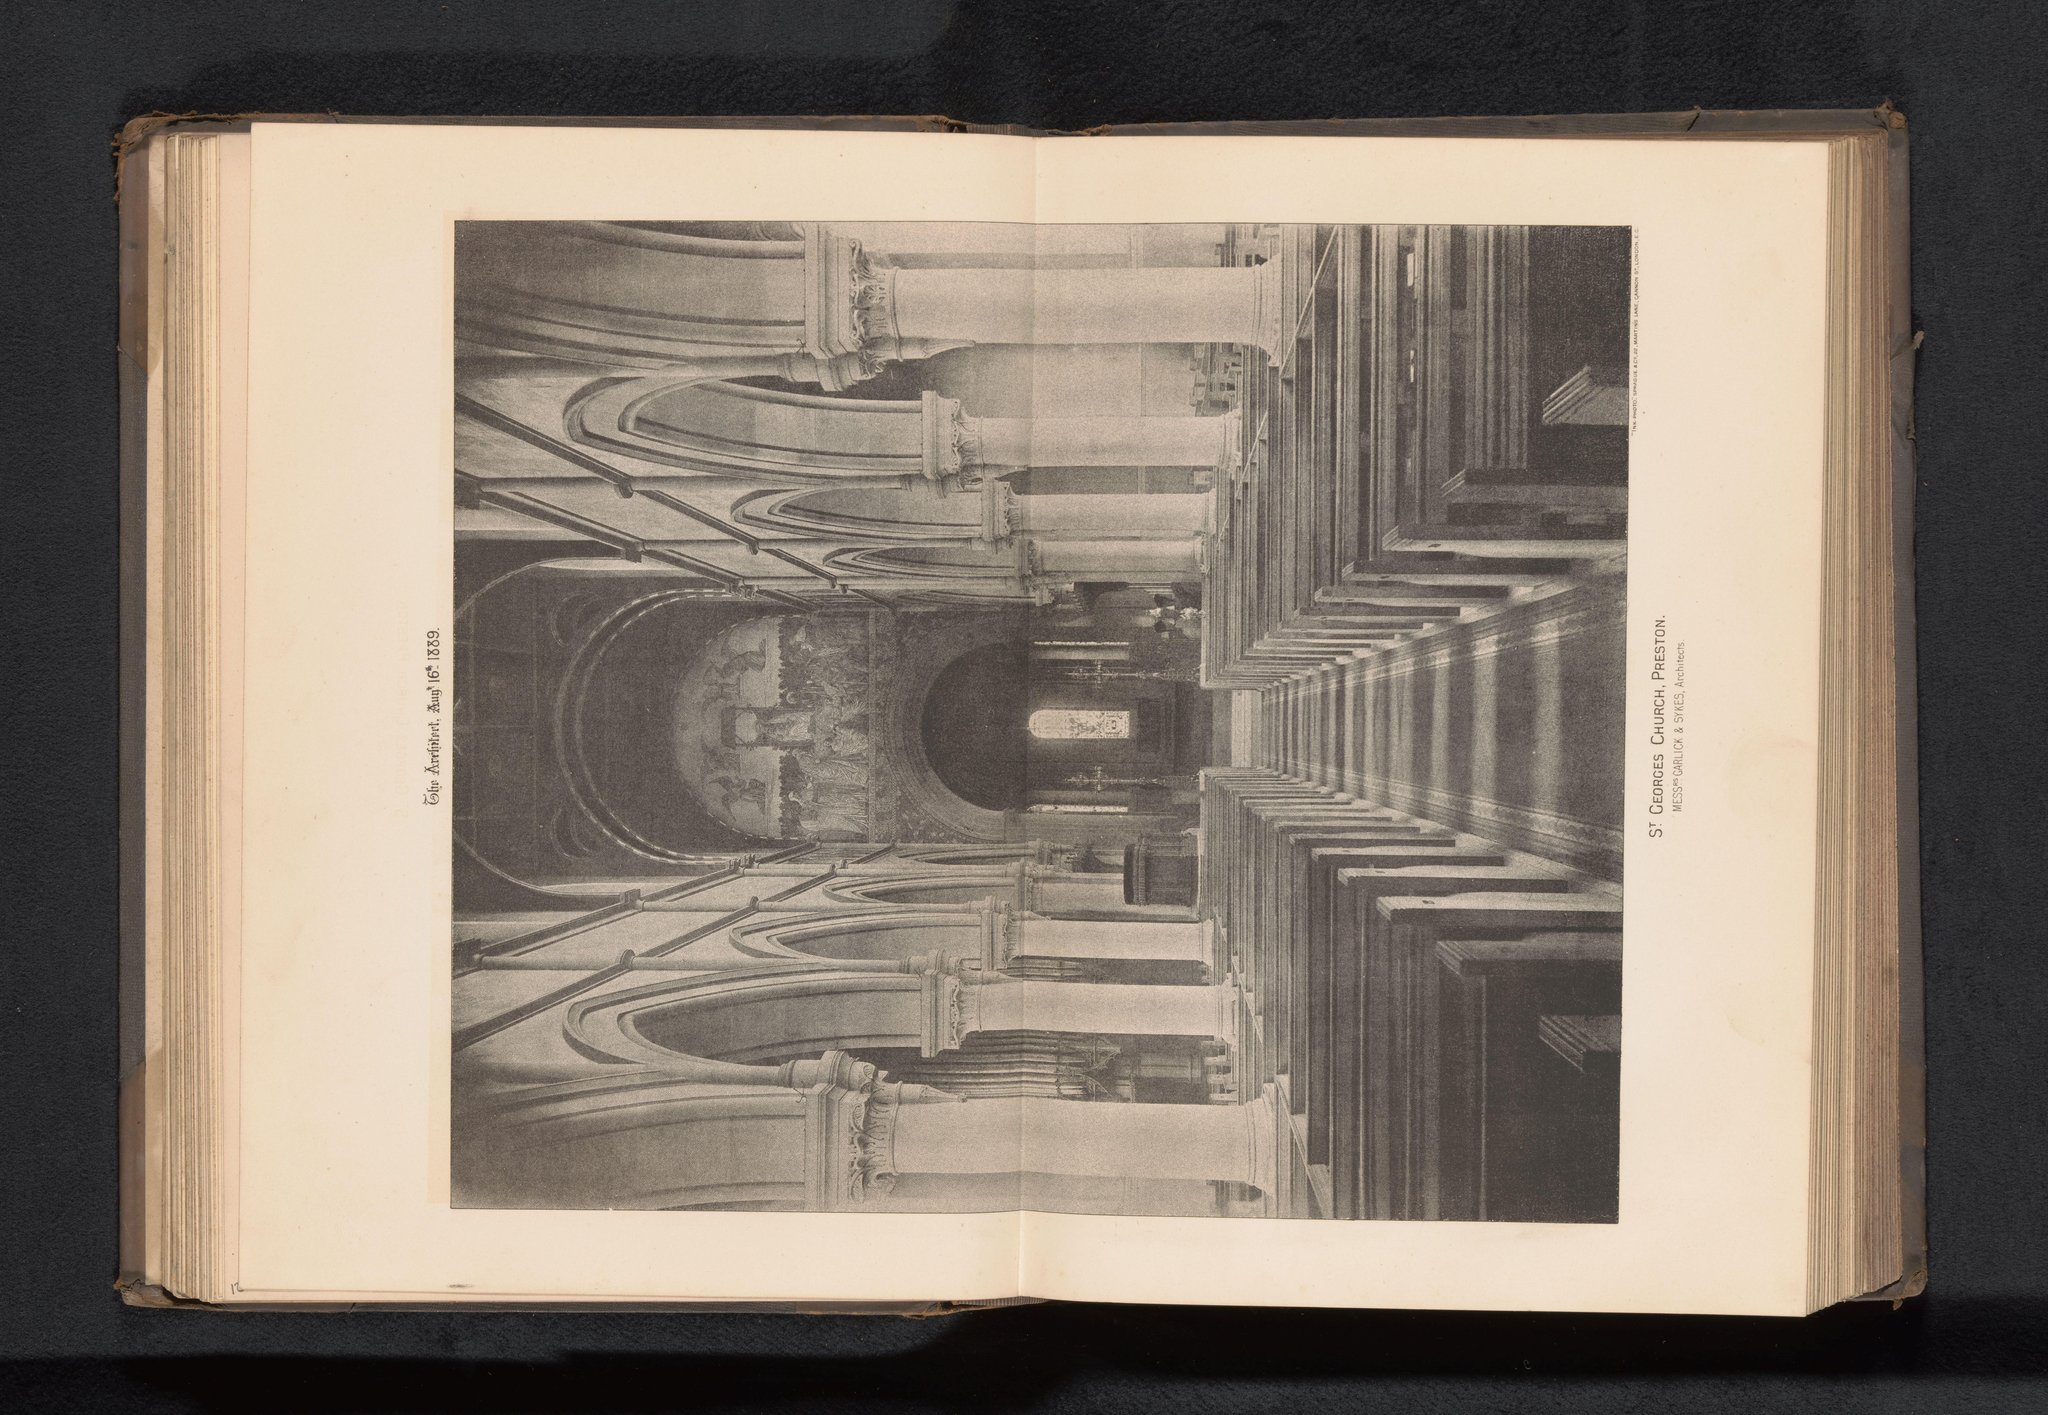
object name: page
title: St. Georges Church, Preston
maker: Anonymous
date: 1884-1889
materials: paper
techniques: photolithography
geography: preston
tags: interior of church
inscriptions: inscription: ‘MESSrs Garlick & Sykes, Architect’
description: Prent op zesde ongenummerde pagina na pagina 90.